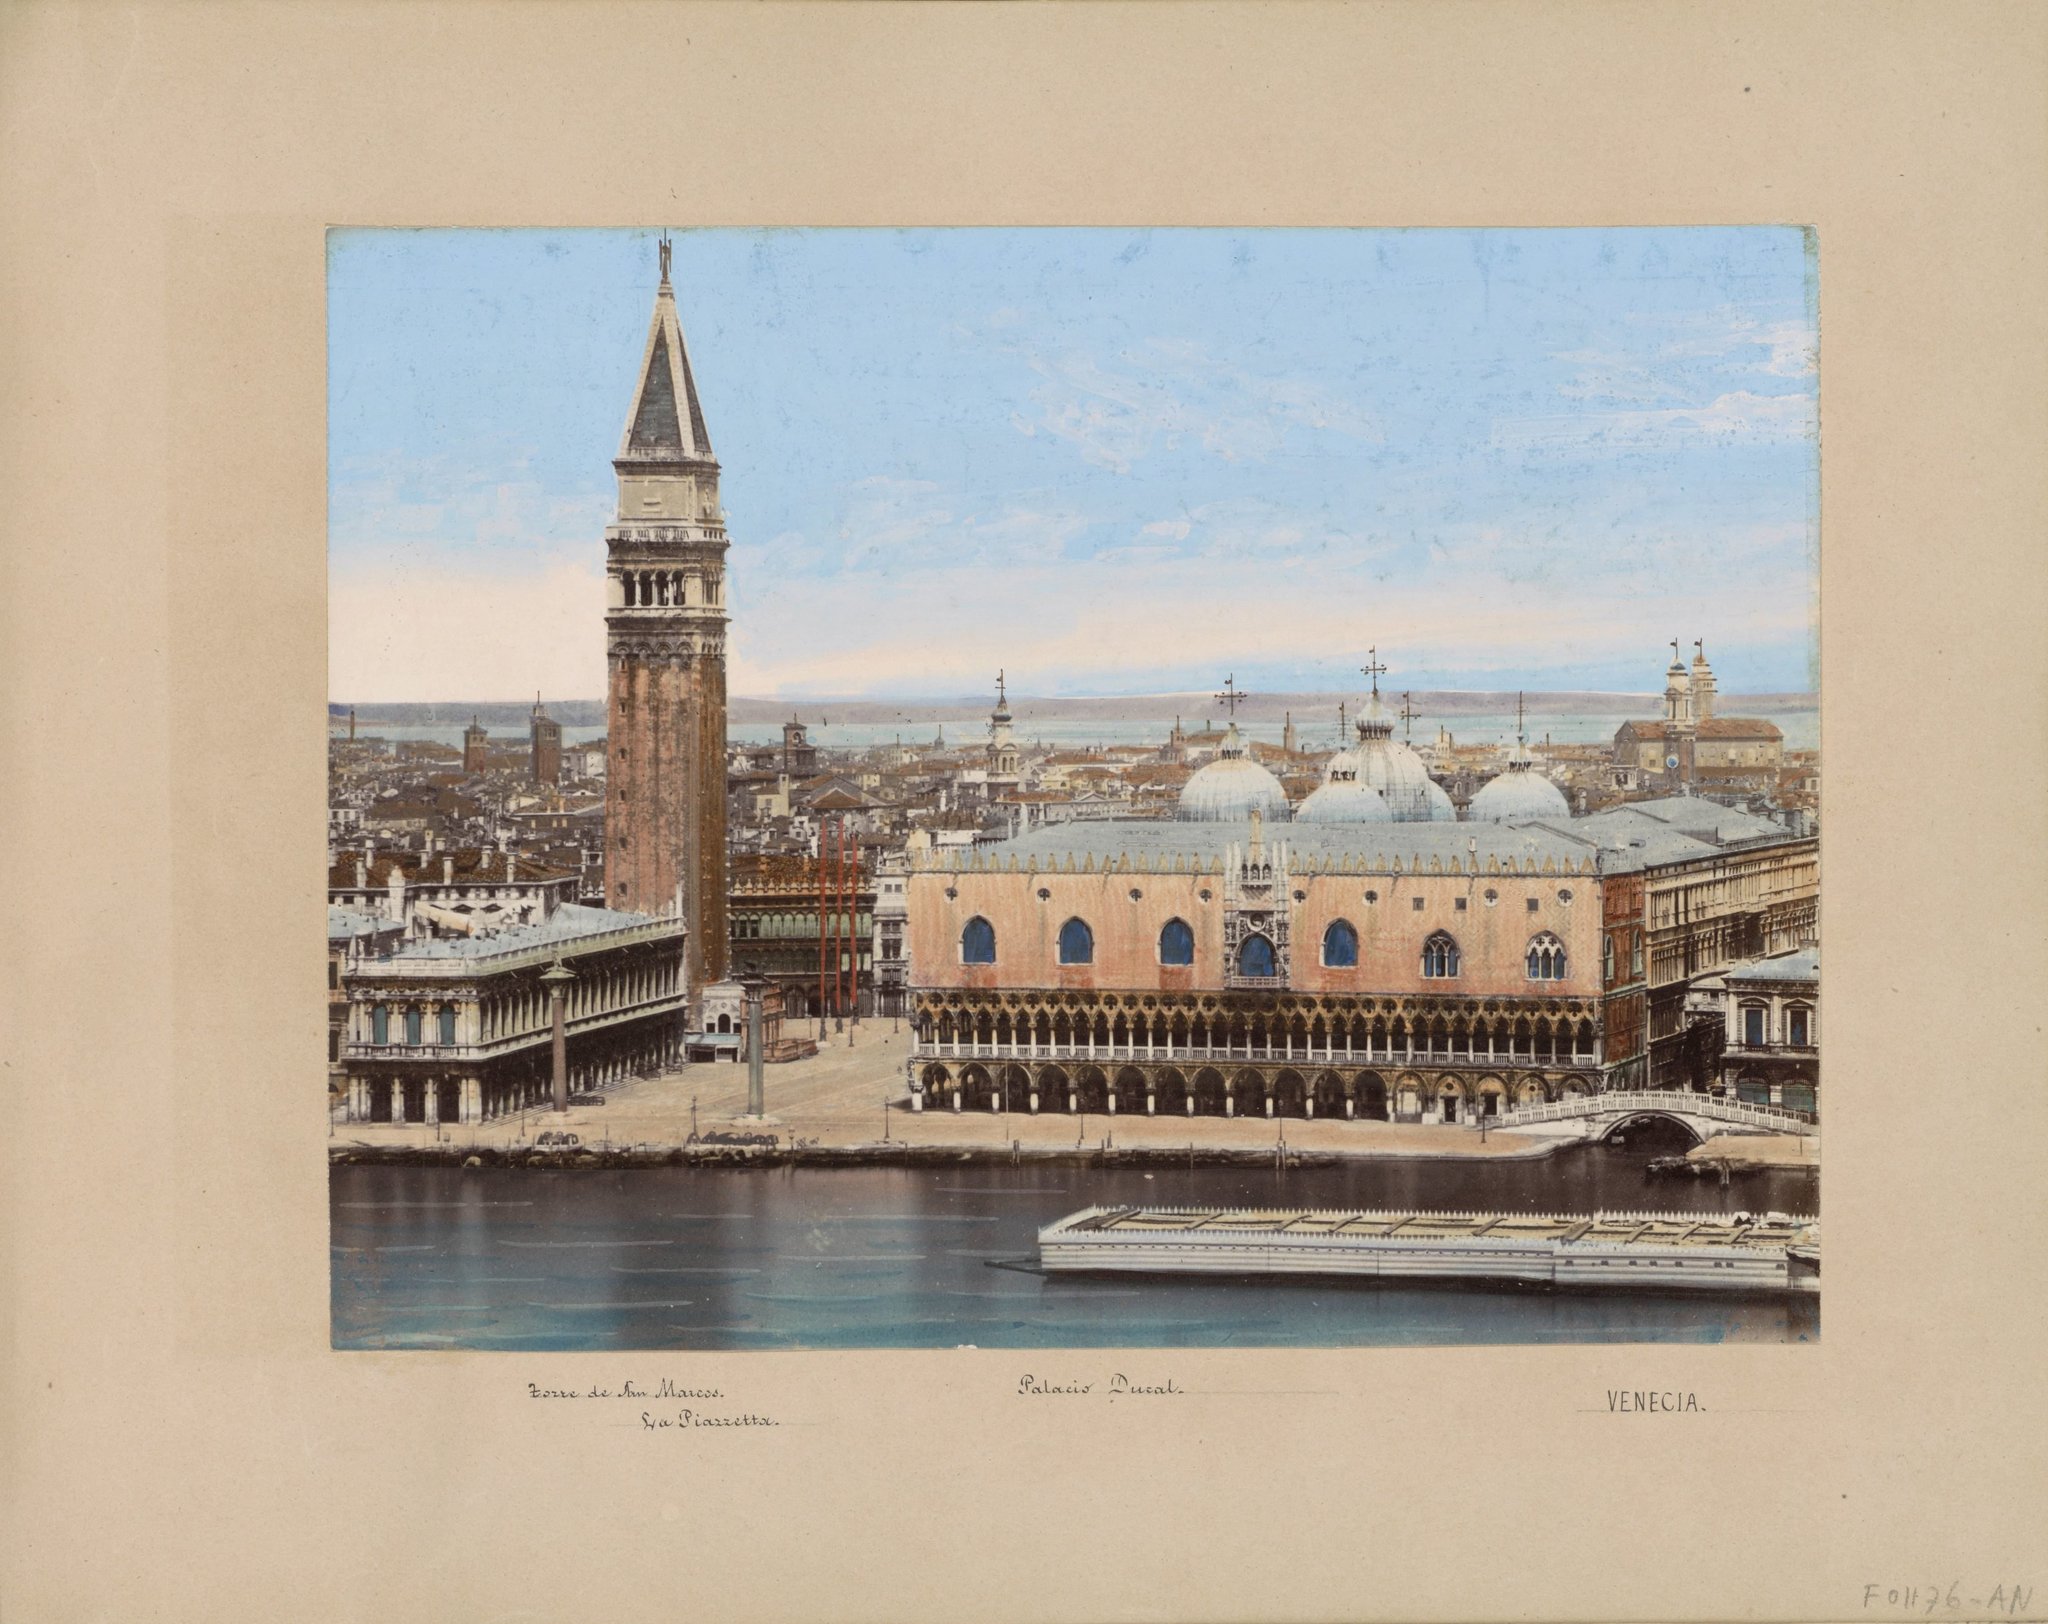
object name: photograph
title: Gezicht op het Dogepaleis, de Campanile en omliggende gebouwen in Venetië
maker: Anonymous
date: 1850-1876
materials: paint, photographic support, watercolor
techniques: albumen print, hand coloring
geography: venice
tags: parts of church exterior and annexes: campanile, palace, travelling; tourism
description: Onderdeel van Reisalbum met foto's en tekeningen van Manuel Mayo 1876.